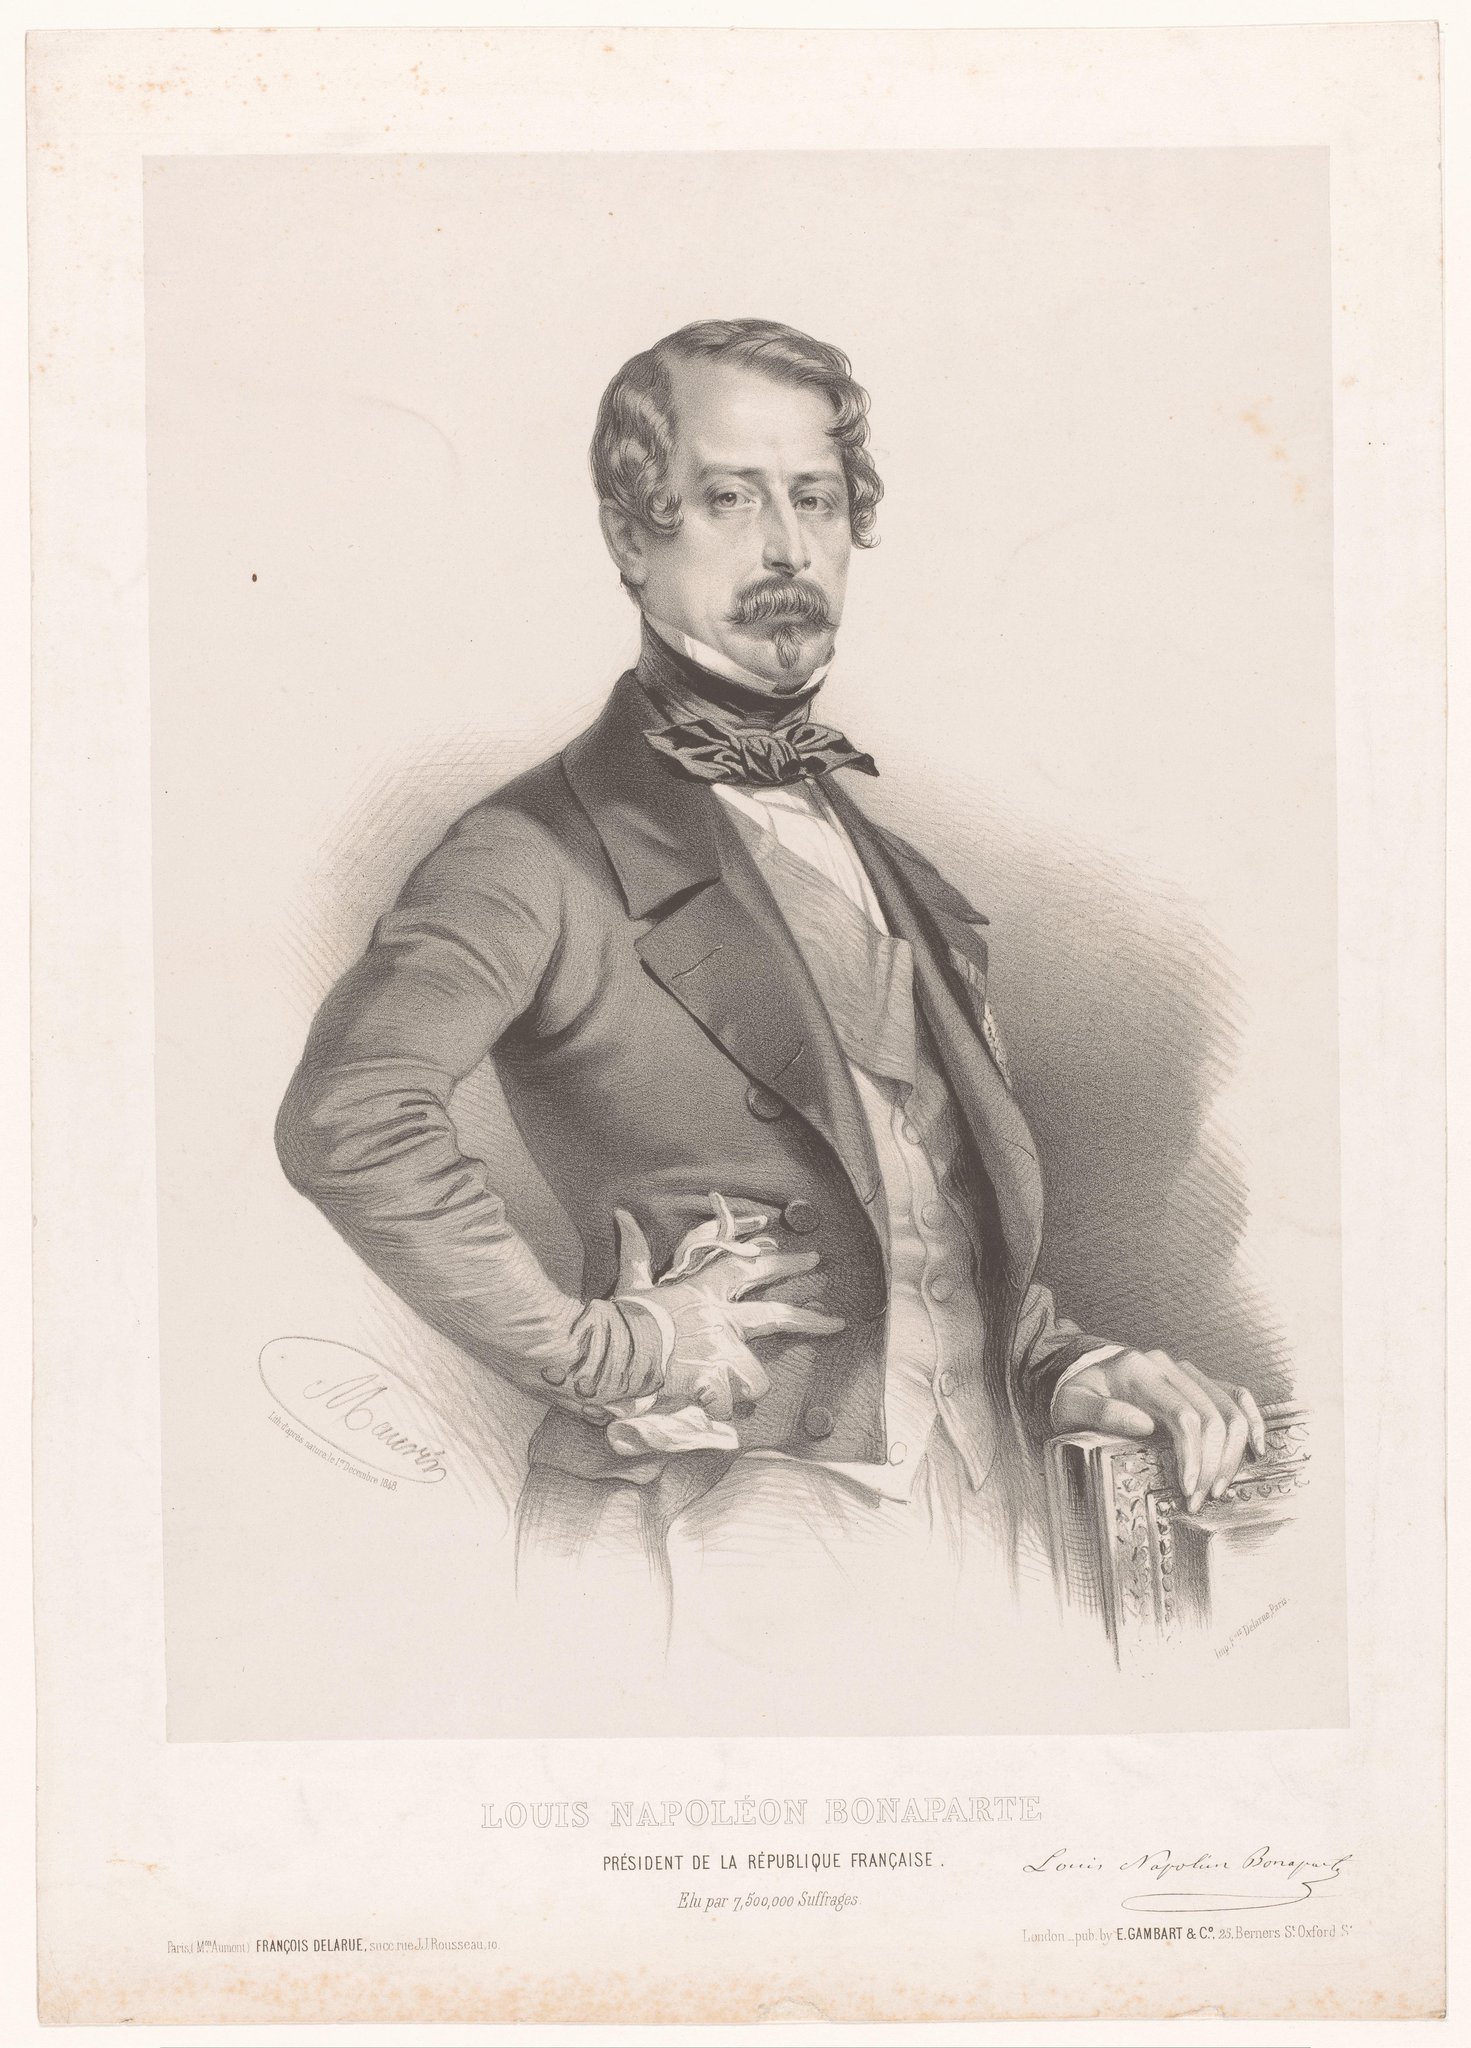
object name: print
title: Louis Napoléon Bonaparte, président de la République Française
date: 1848-1852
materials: paper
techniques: lithograph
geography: london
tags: paris, london, napoleon iii (keizer der fransen), historical persons, emperor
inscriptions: collector's mark: Lugt 2228